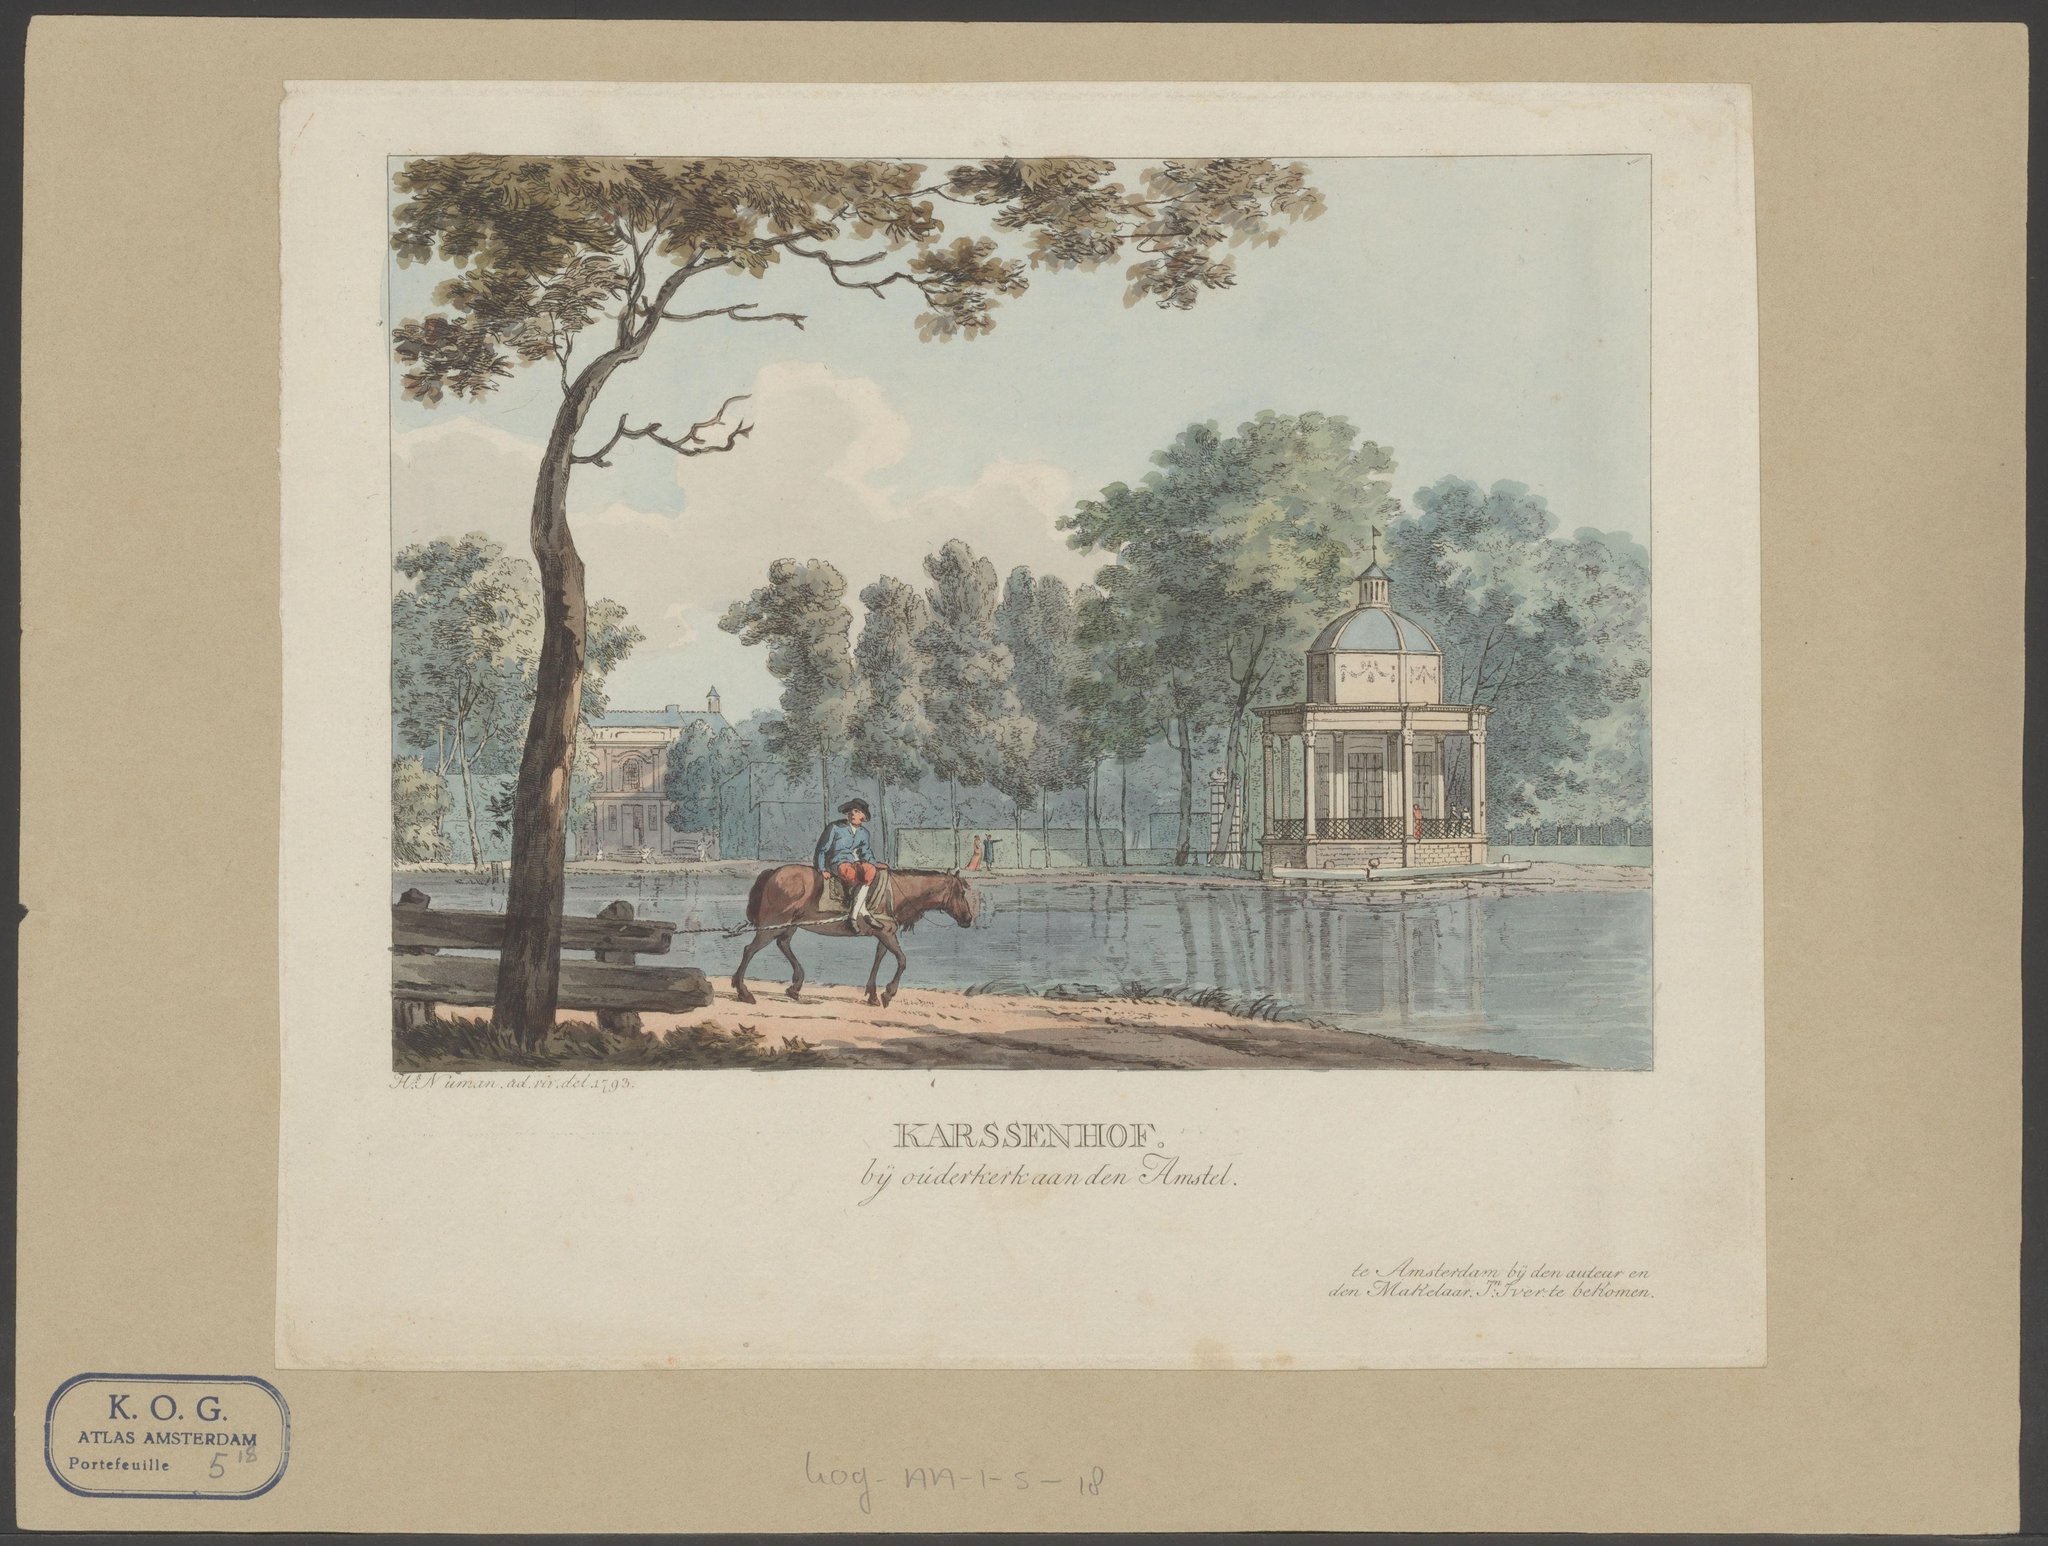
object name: print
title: Karssenhof bij ouderkerk aan den Amstel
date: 1793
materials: paper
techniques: etching, hand coloring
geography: amsterdam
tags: river, rural housing, e.g. country-house, villa, cottage, village, pergola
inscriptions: collector's mark: ‘5 18’ Lugt 1641b, inscription: ‘Auctie RWP de Vries / Ma (Mei?). 81’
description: Prent gebruikt in: Numan, Hermanus. Vierentwintig printtekeningen met couleuren, verbeeldende Hollandsche buitenplaatzen. Amsterdam: Jan IJver, Jan Willem Smit en Hermanus Numan, 1797.